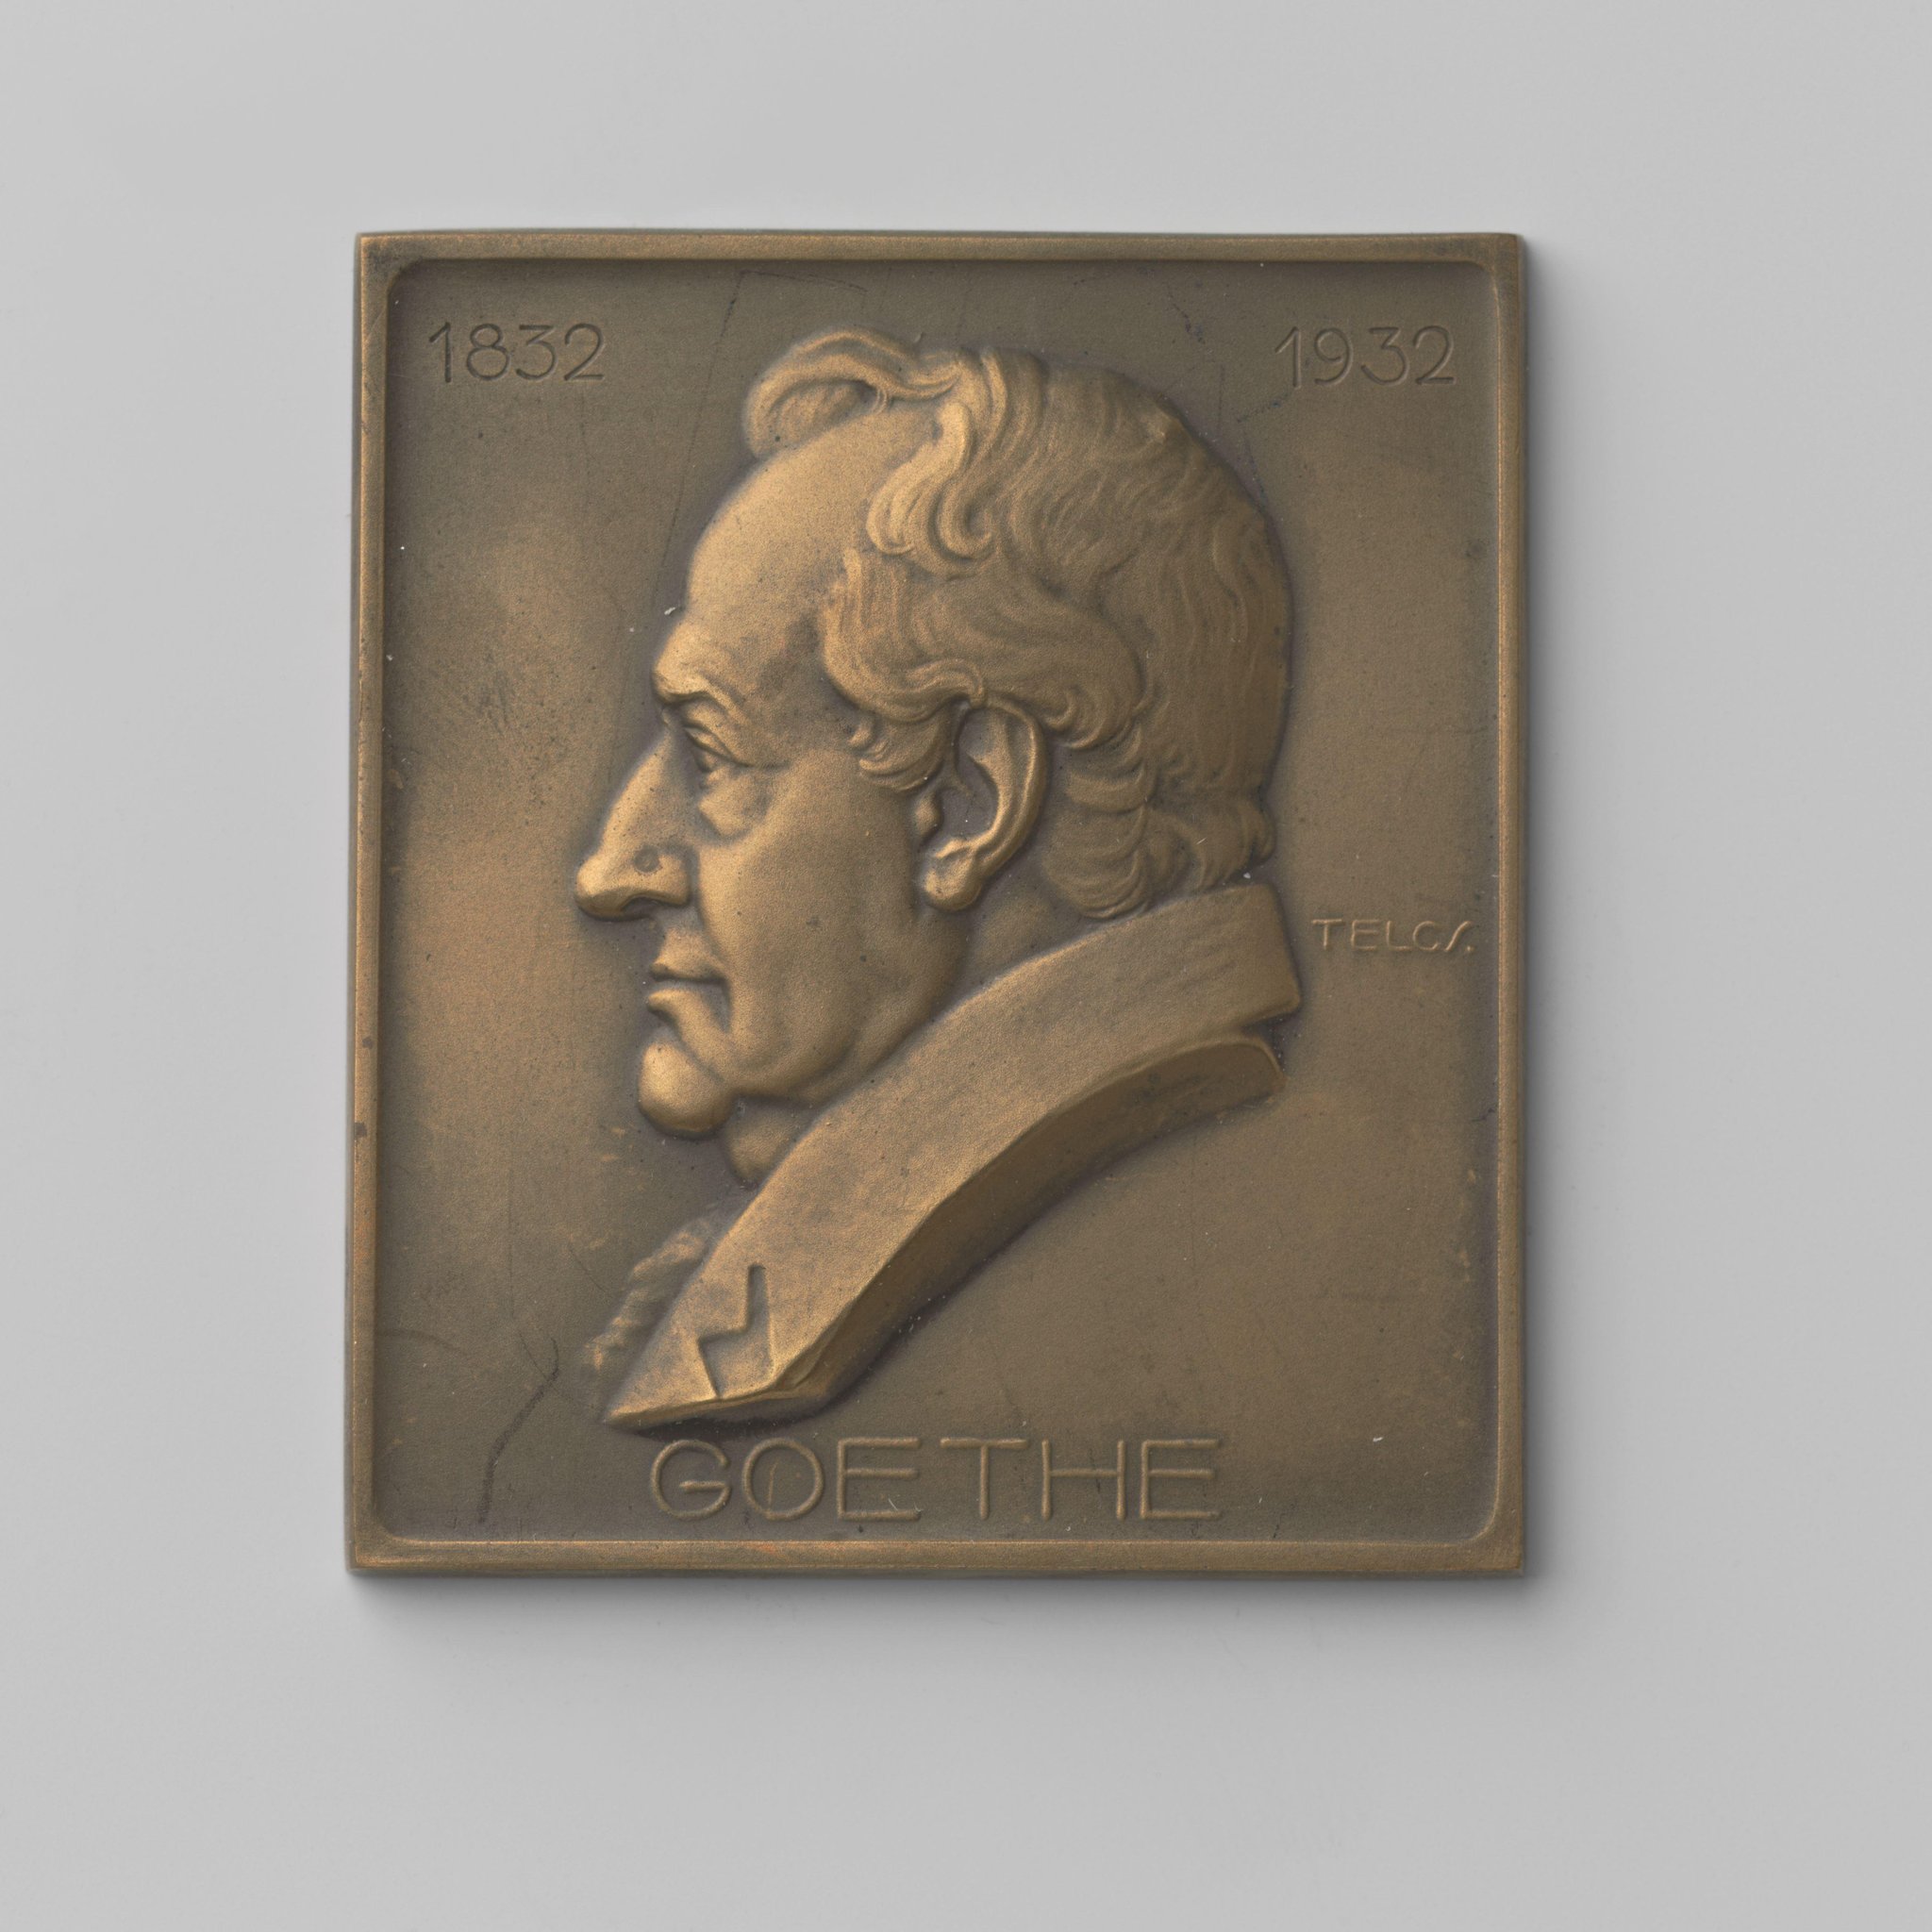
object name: history medal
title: Honderdjarige herdenking van het overlijden van Goethe 1932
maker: eduard telcs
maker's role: medailleur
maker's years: 1872-1928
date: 1932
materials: bronze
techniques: striking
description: Rechthoekige bronzen plaquette, op de voorzijde het portret van Goethe naar links met onderaan zijn naam en bovenaan twee jaartallen, de keerzijde glad.